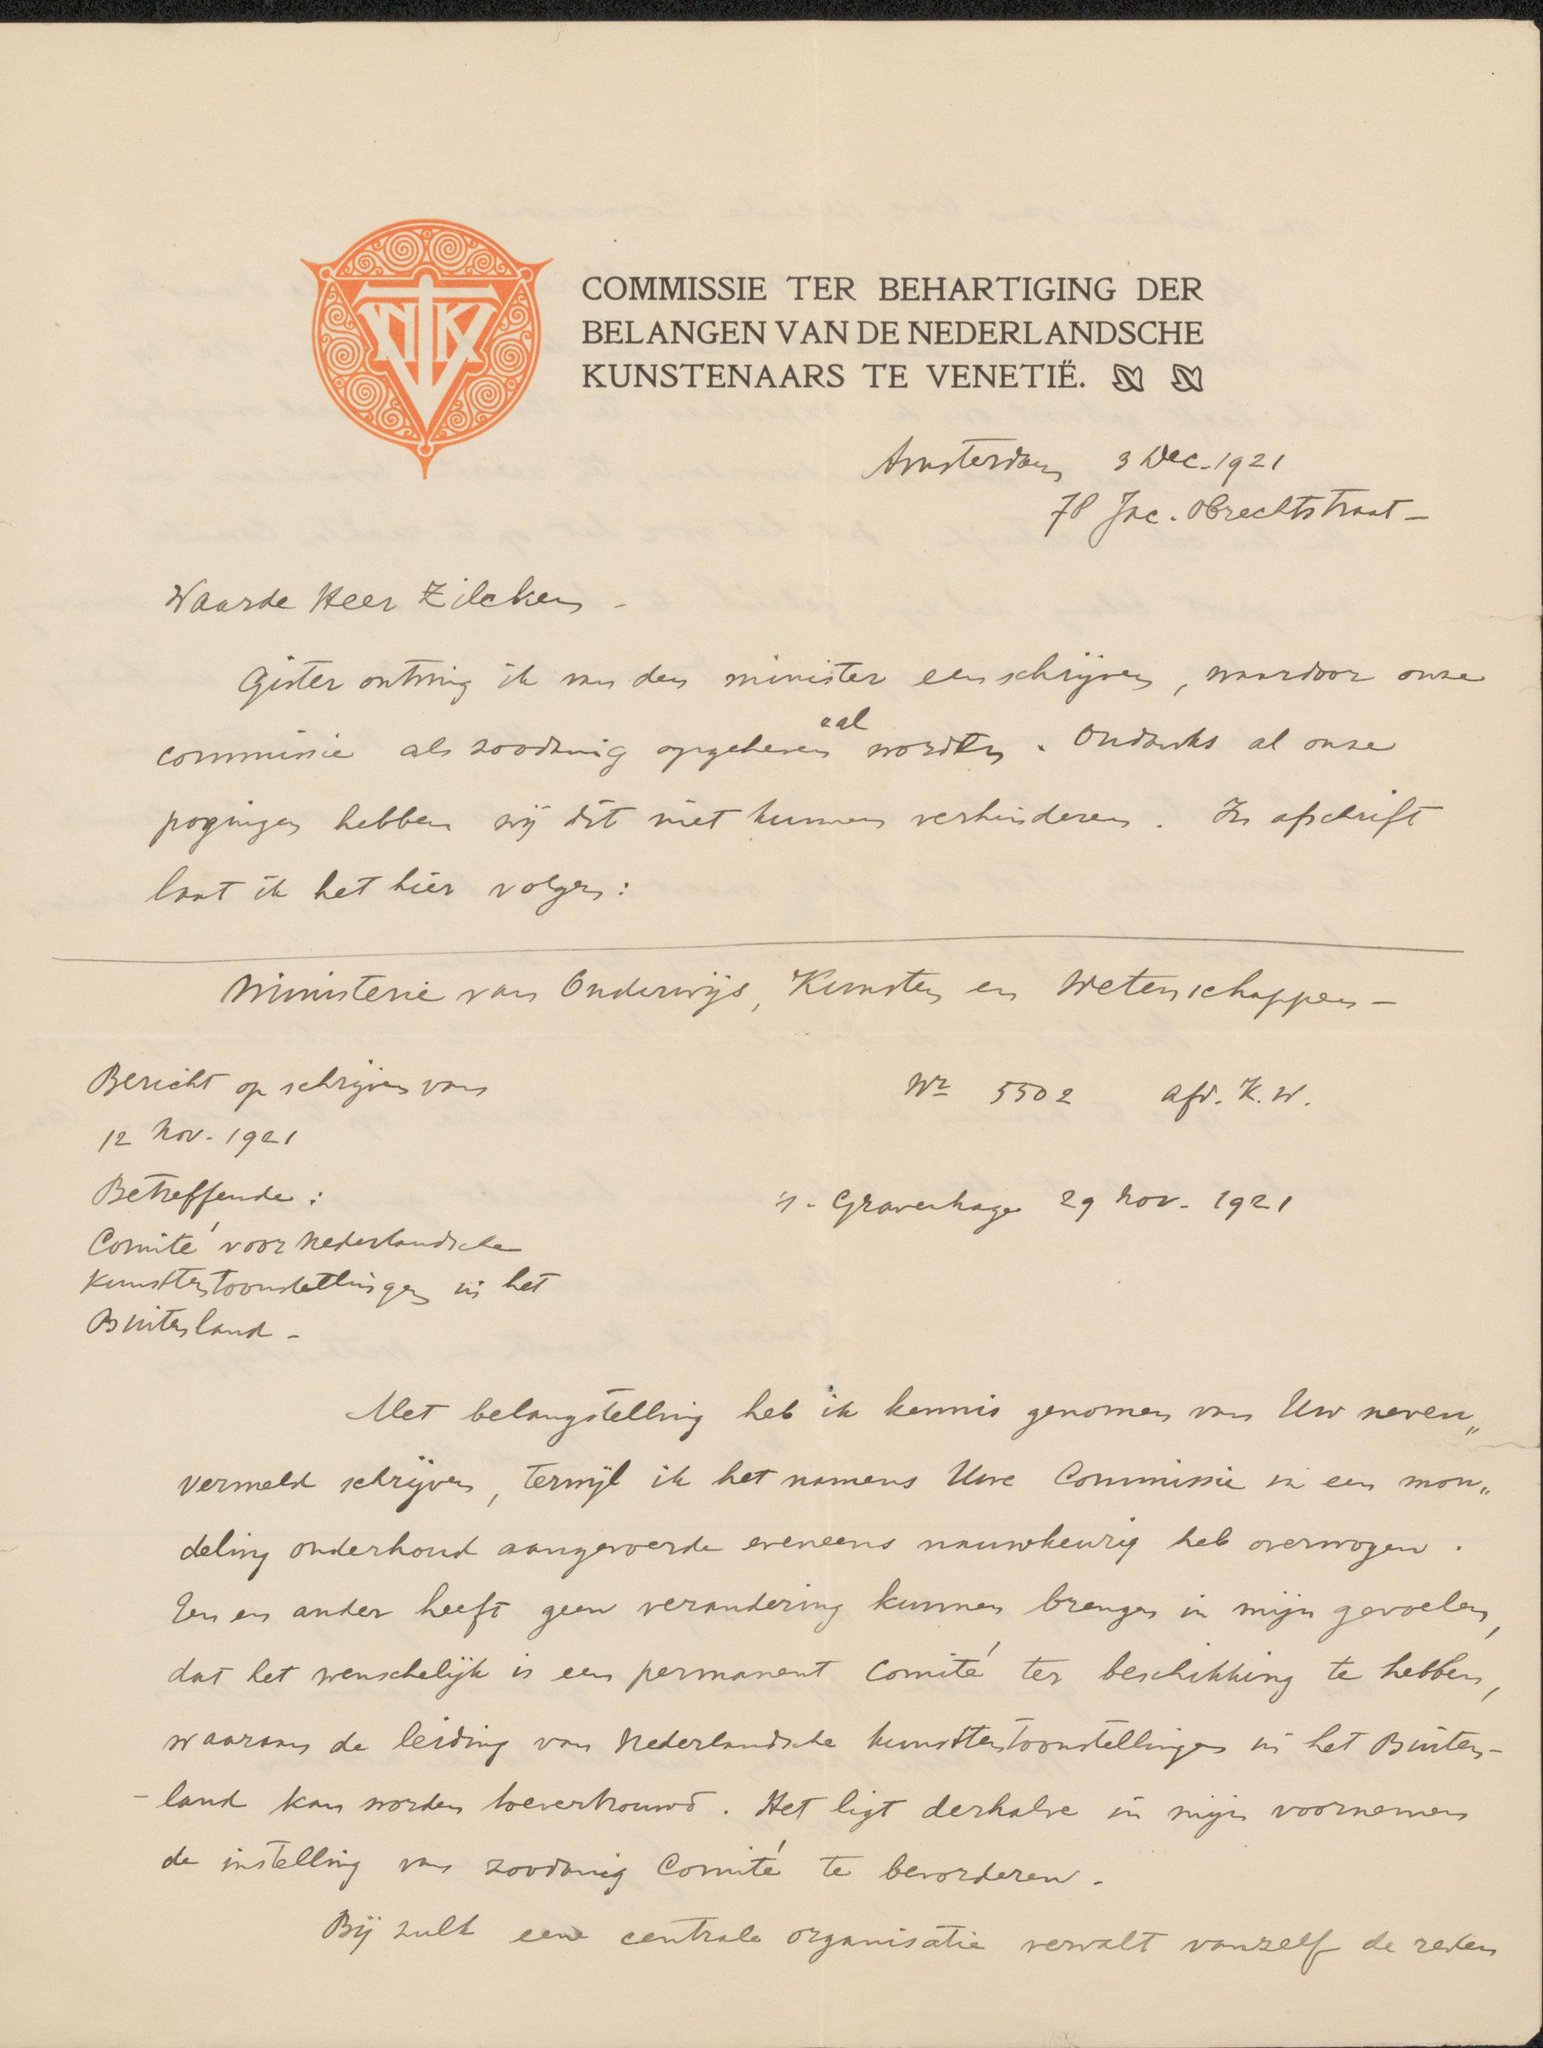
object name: letter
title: Brief aan Philip Zilcken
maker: ernst van der minne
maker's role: draughtsman, painter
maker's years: 1883-1932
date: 1921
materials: ink, paper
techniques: pen, printing, writing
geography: amsterdam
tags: haarlem, painter, print maker, draughtsman, anton l. koster, nicolaas bastert, vittorio pica, the hague, philip zilcken, exhibition ~ art, venice